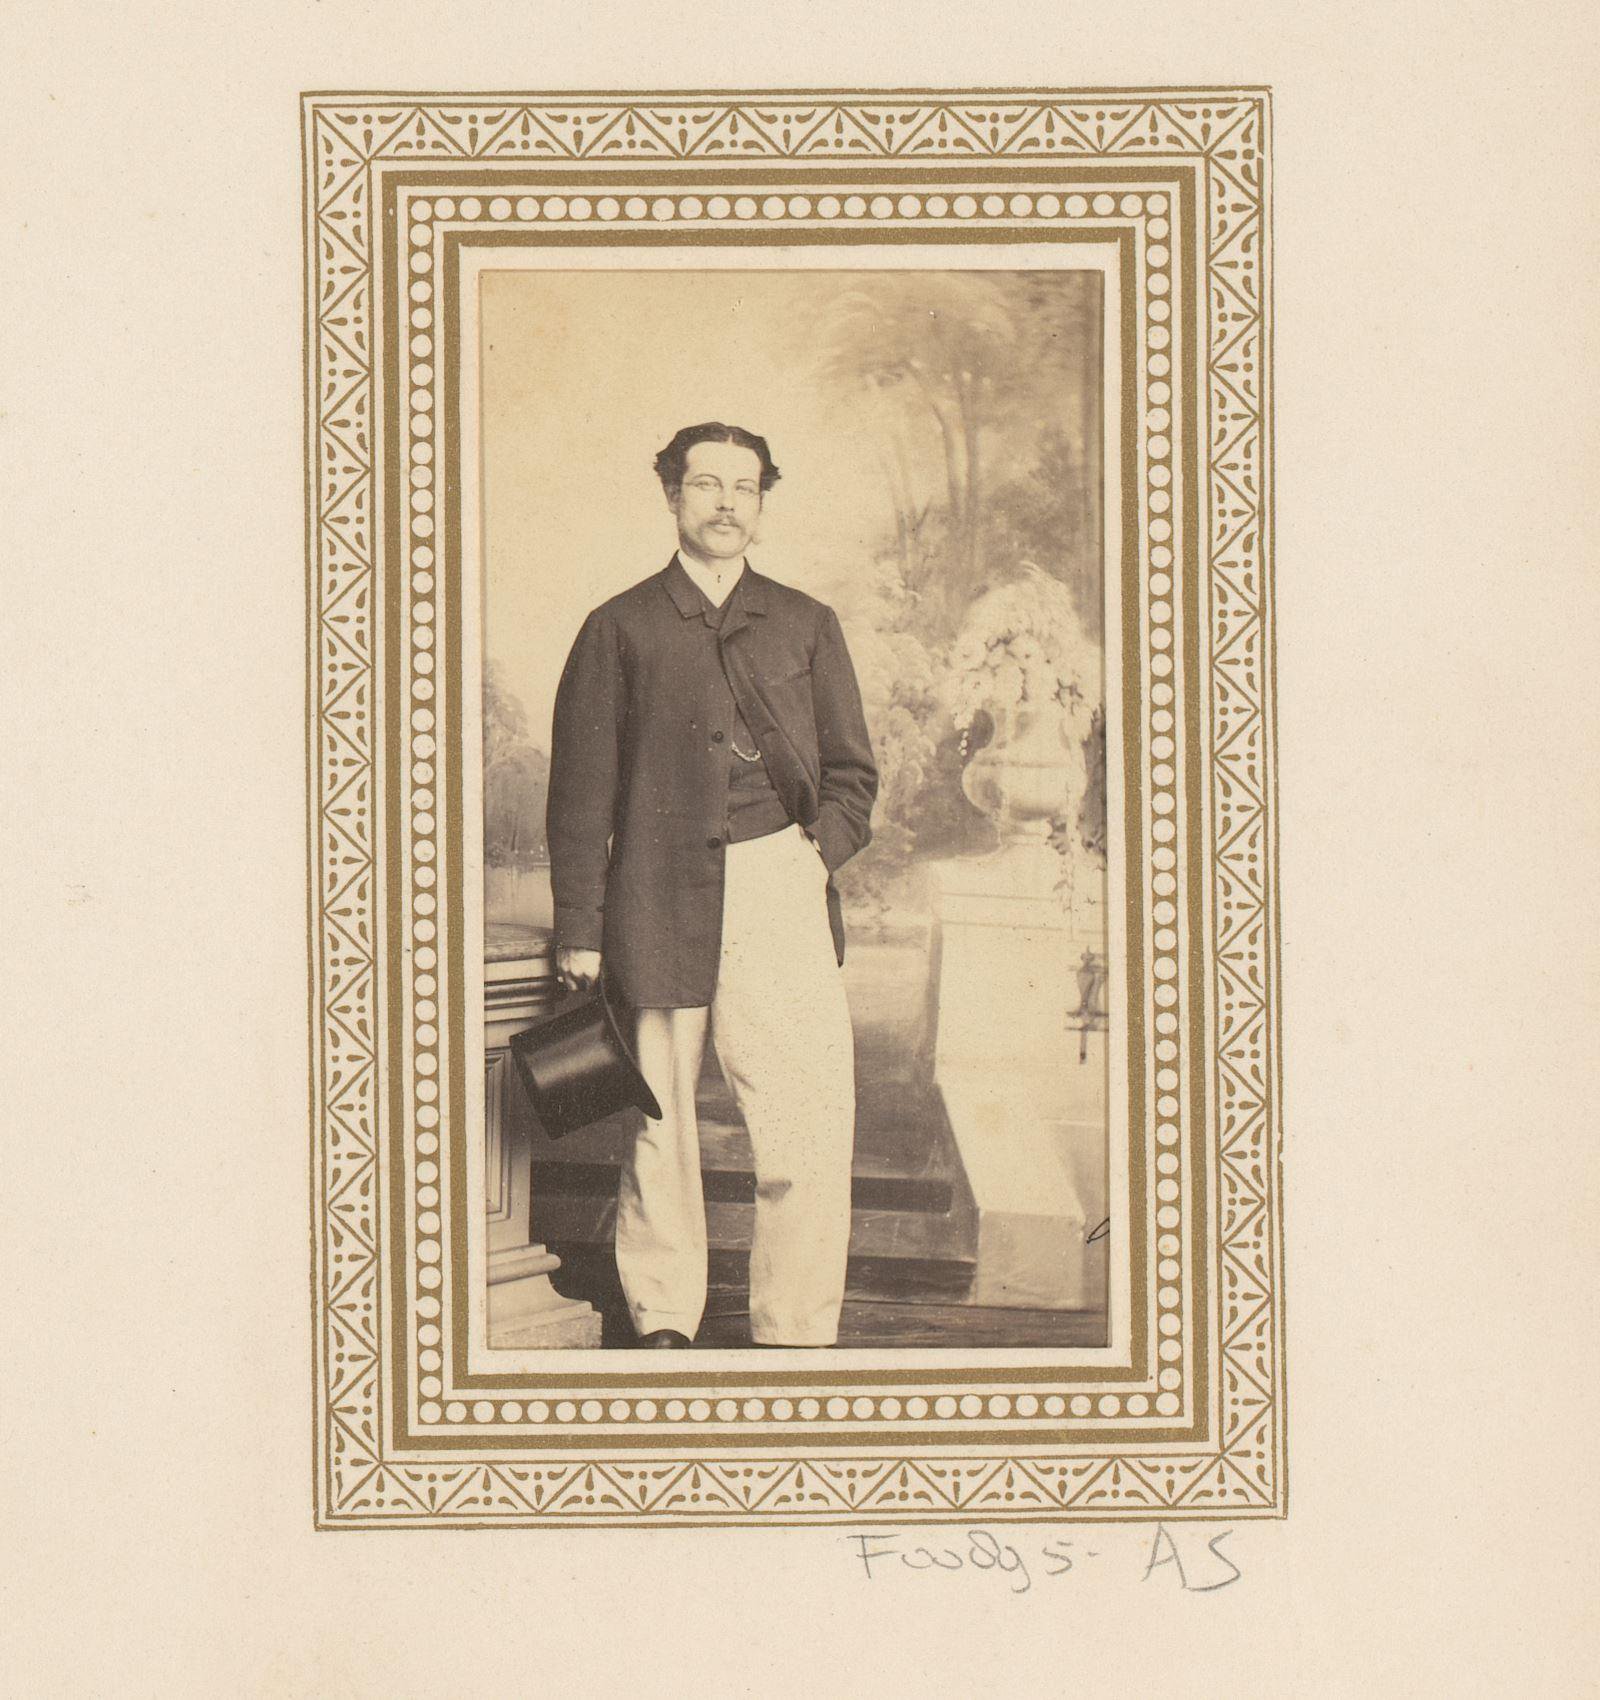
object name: photograph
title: Portret van een man met snor en in de hand een hoge hoed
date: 1855-1890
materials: cardboard, photographic support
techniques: albumen print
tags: moustache, adult man, historical persons, head-gear: top hat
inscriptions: inscription: ‘Photographed by Clarkington & Co./ Sponsalia/ 246 & 248/ Regent St.’